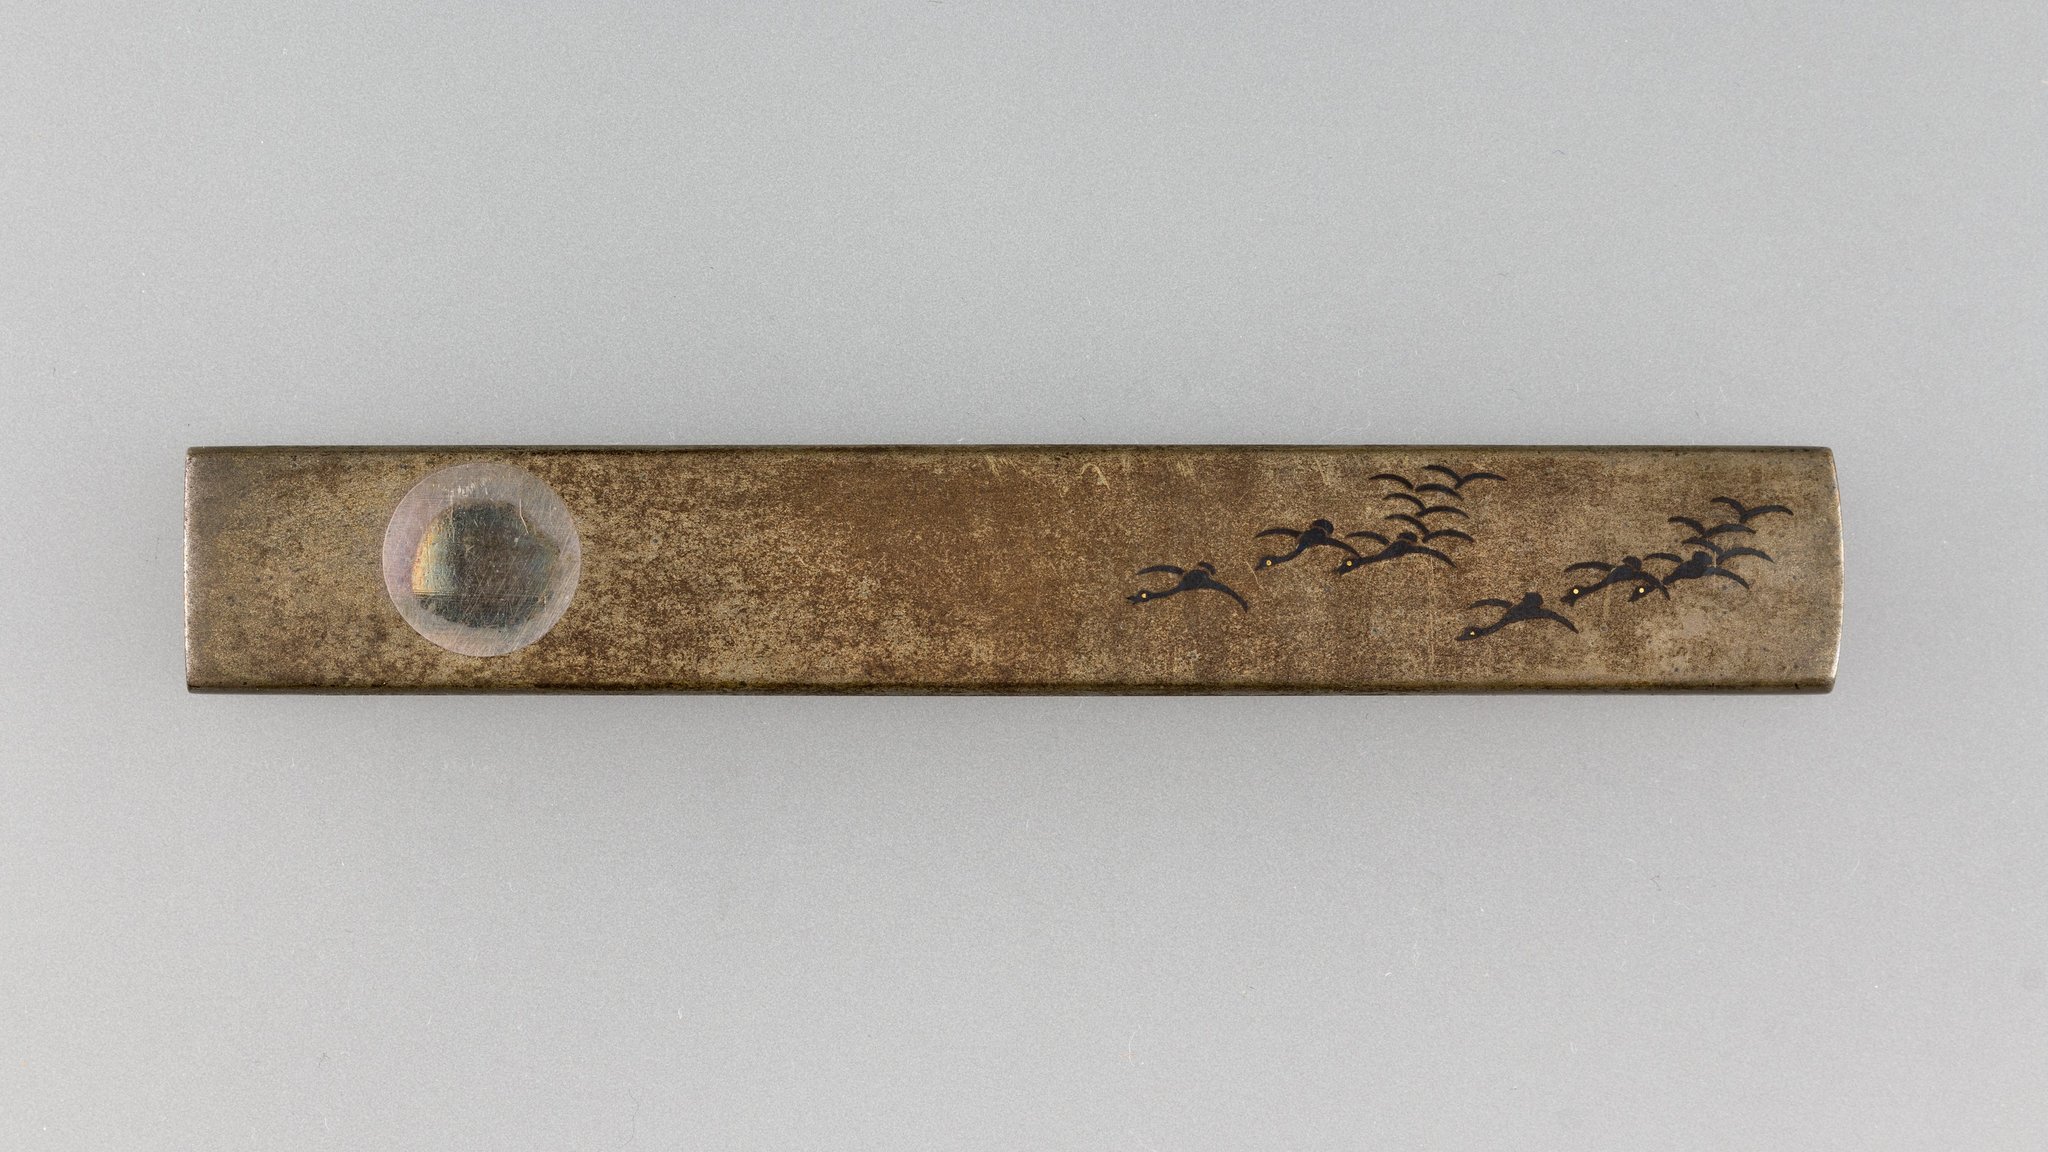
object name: knife handle kozuka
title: Knife Handle (Kozuka)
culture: japanese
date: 1801-1900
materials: gold alloy, silver alloy, silver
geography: japan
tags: birds